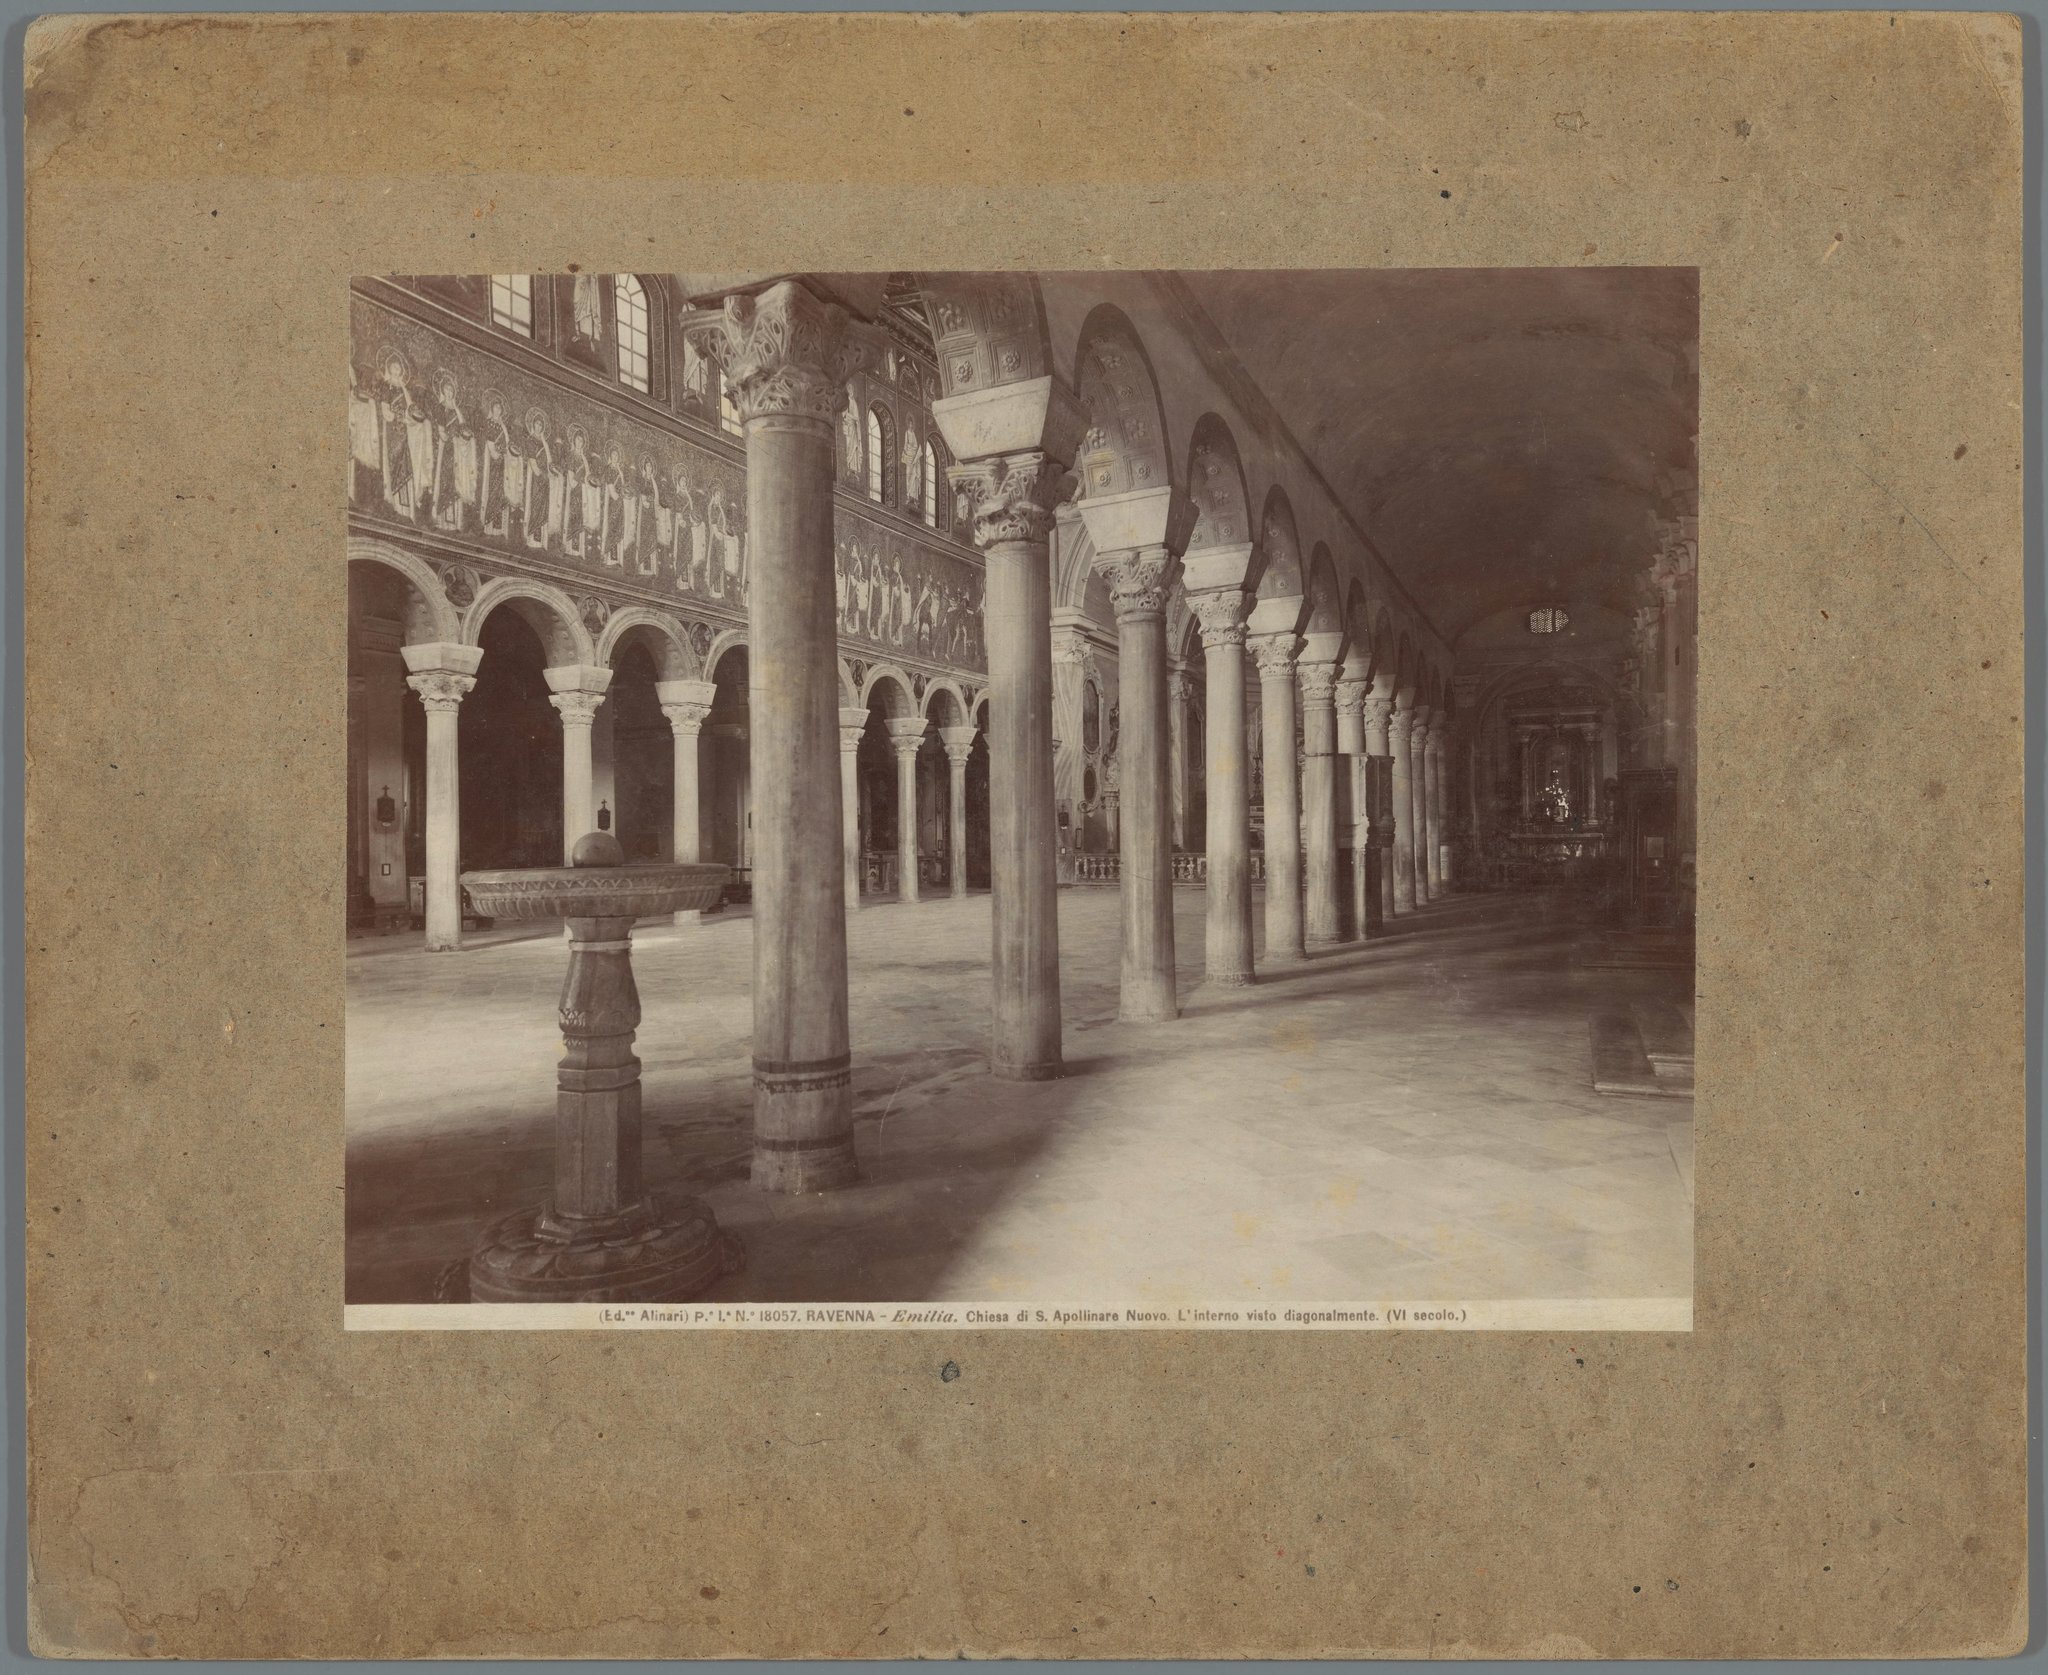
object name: photograph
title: RAVENNA - Emilia. Chiesa di. S. Apollinare Nuovo. L'interno visto diagonalmente. (VI secolo.)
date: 1875-1900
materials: cardboard, photographic support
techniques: albumen print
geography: basiliek van sant'apollinare nuovo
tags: colonnade, interior of church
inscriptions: number: ‘P.e I.a N.o 18057.’, collector's mark: Lugt 3937, inscription: ‘O.C. 67’